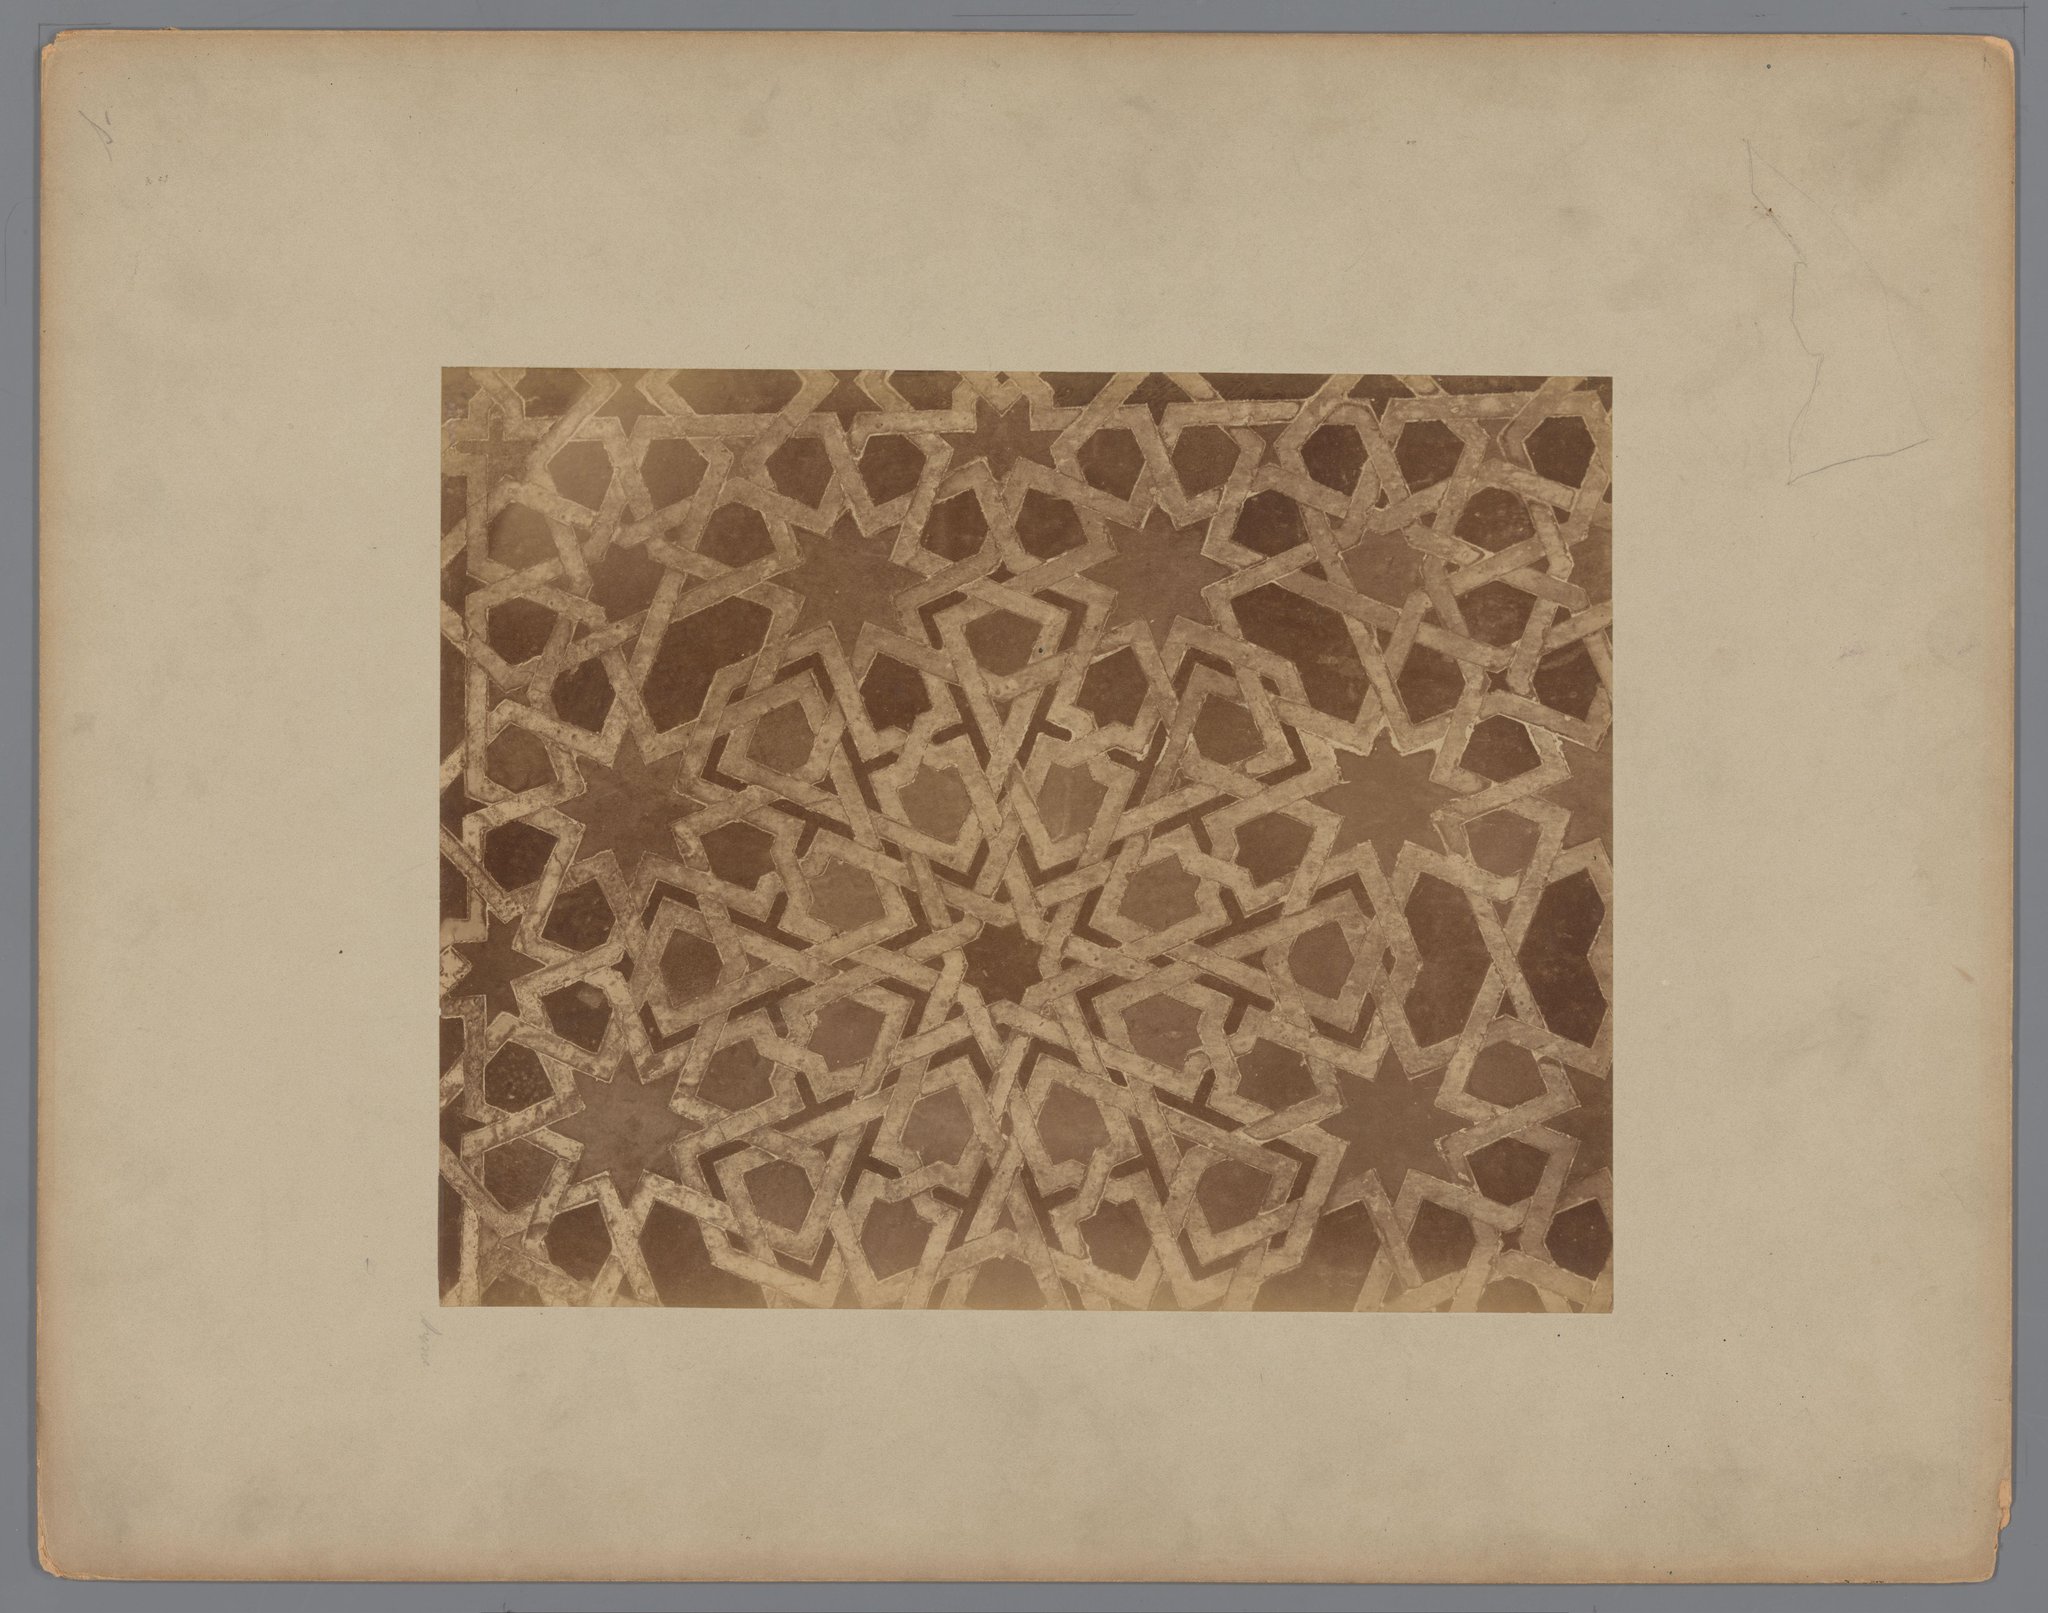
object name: photograph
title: Mozaïek van faience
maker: Anonymous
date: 1875-1900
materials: cardboard, photographic support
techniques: albumen print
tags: ornament ~ starforms, flat decoration ~ applied arts (+ islamic art), interior ~ representation of a building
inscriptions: collector's mark: Lugt 3937, inscription: ‘Syrie’